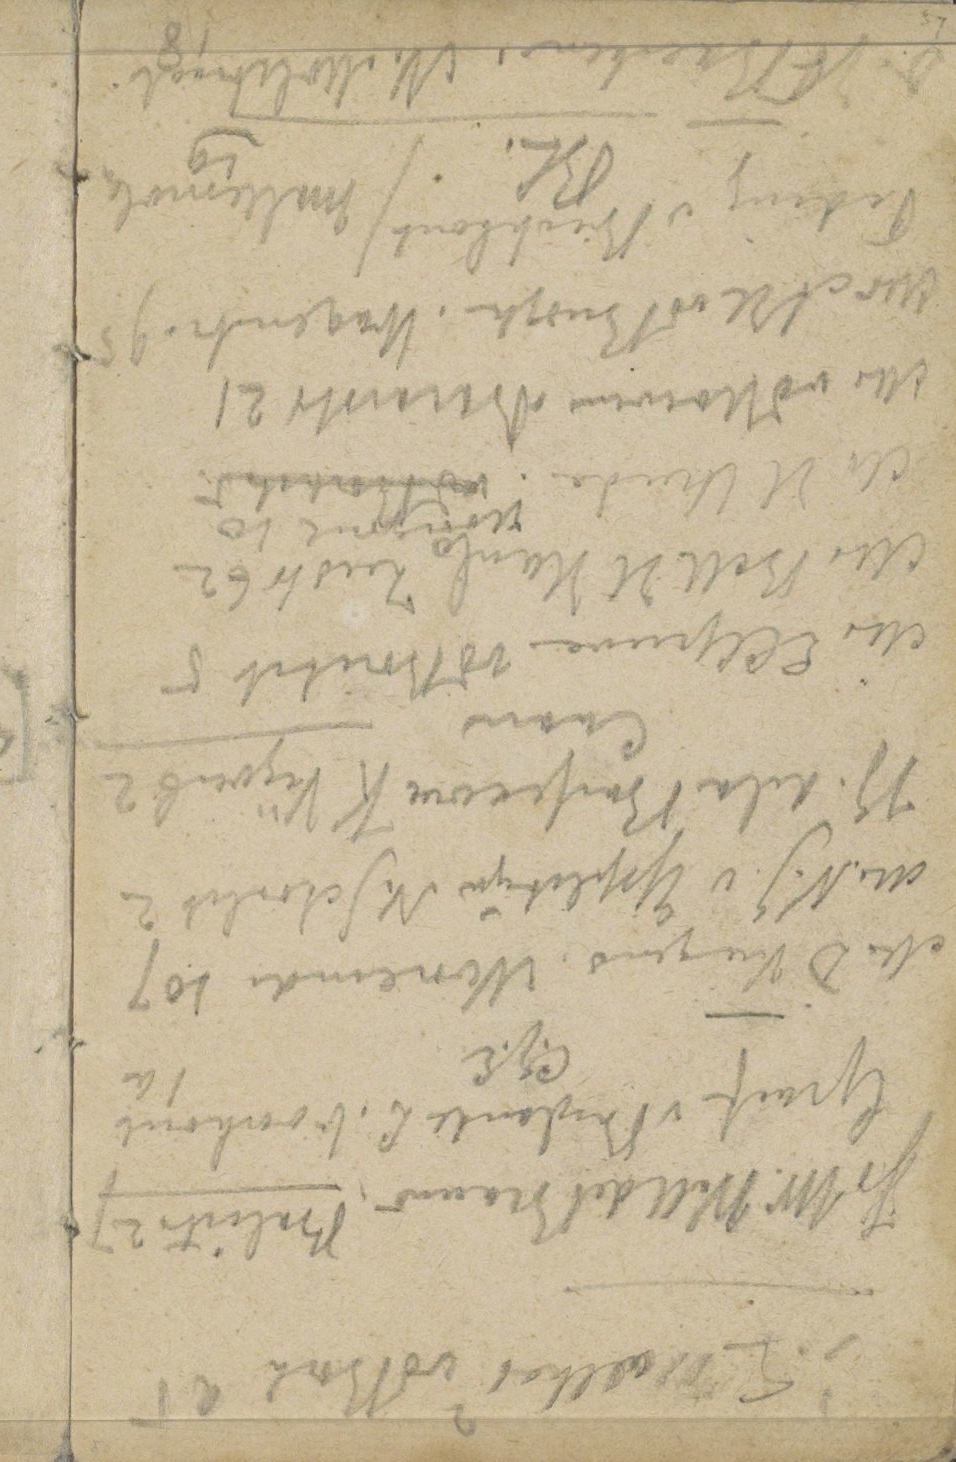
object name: sketchbook leaf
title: Annotaties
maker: george hendrik breitner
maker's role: draughtsman, painter, print maker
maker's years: 1857-1923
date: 1881-1883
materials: paper, pencil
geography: south holland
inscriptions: annotation: ‘E Walker[?] vd Bork[?] 25/ Jr M.W.A. de Braun[?] Balistr 27/ Graaf v. Bylandt L. Voorhout/ 1a/ [...]/ M. D Vrigens[?] N[...] 107/ Mr. N.J. v IJspletijn N. Schoolstr 2/ [...] de la Barserou[?] K Vijverb 2/ [...]/ Mr Ellpuve Romboutstr[?] 5/ Mr. Bell. [...] Zeestr 62/ M [...] Vreeda [...] 10/ Mr vd Hoeven Bazarstr 21/ Mr. [...]ootburgh. Wagenstr. 95/ Federig v Beukhout[?]/ BL./ Mallemolen/ 19/ D [...]Baeken[?] N. Molstraat/ 18’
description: Annotaties: namen en adressen. Pagina 57 uit een schetsboek met 43 bladen.